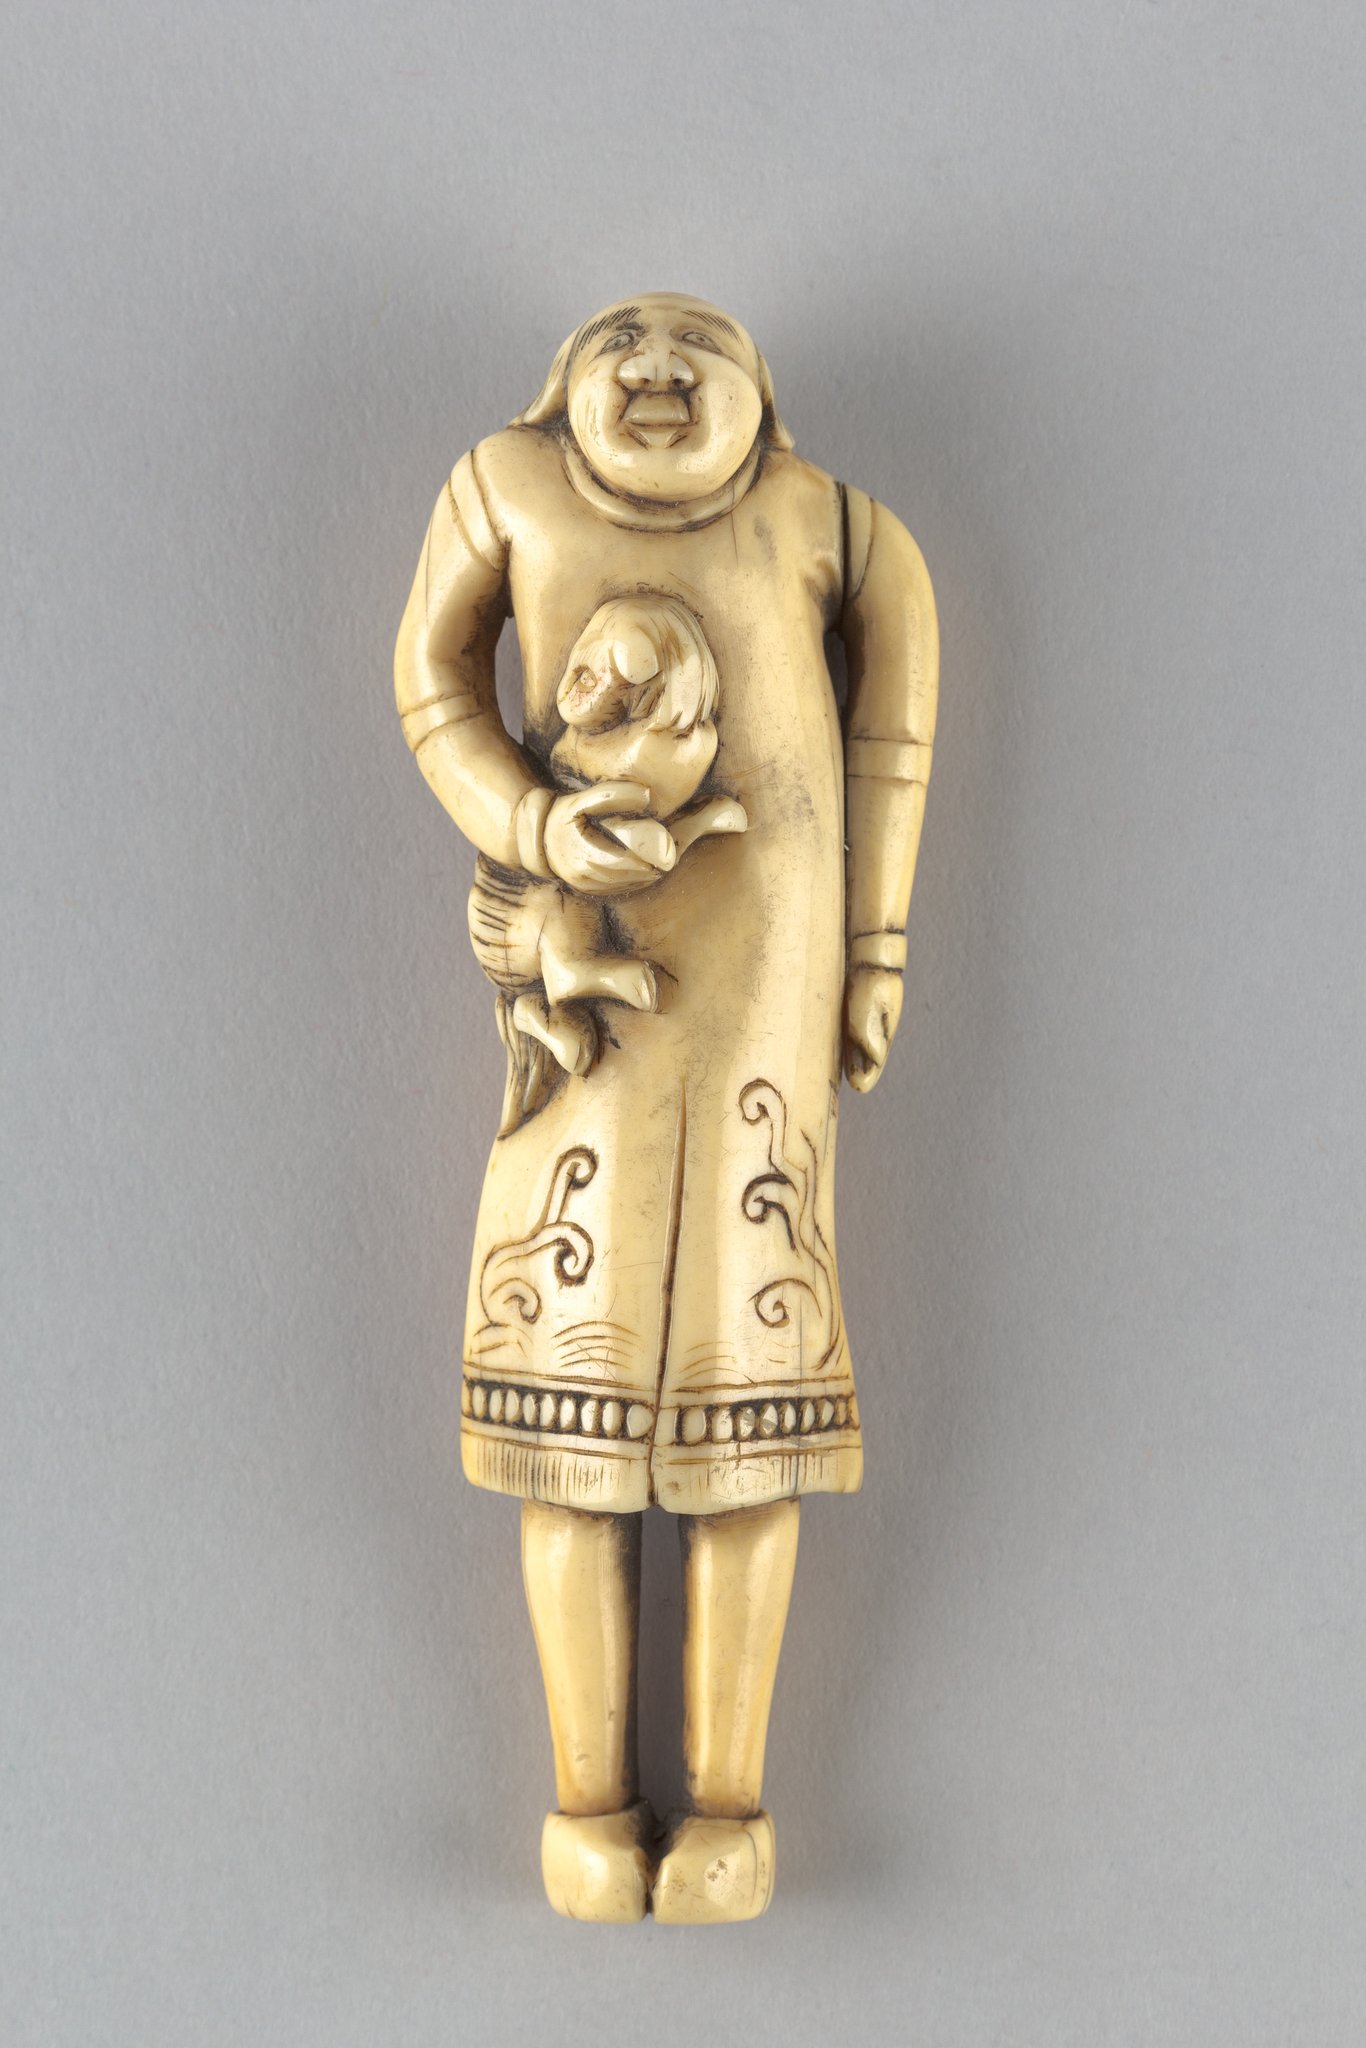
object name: netsuke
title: Netsuke of Foreigner Carrying a Dog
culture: japanese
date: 1801-1900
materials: ivory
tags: men